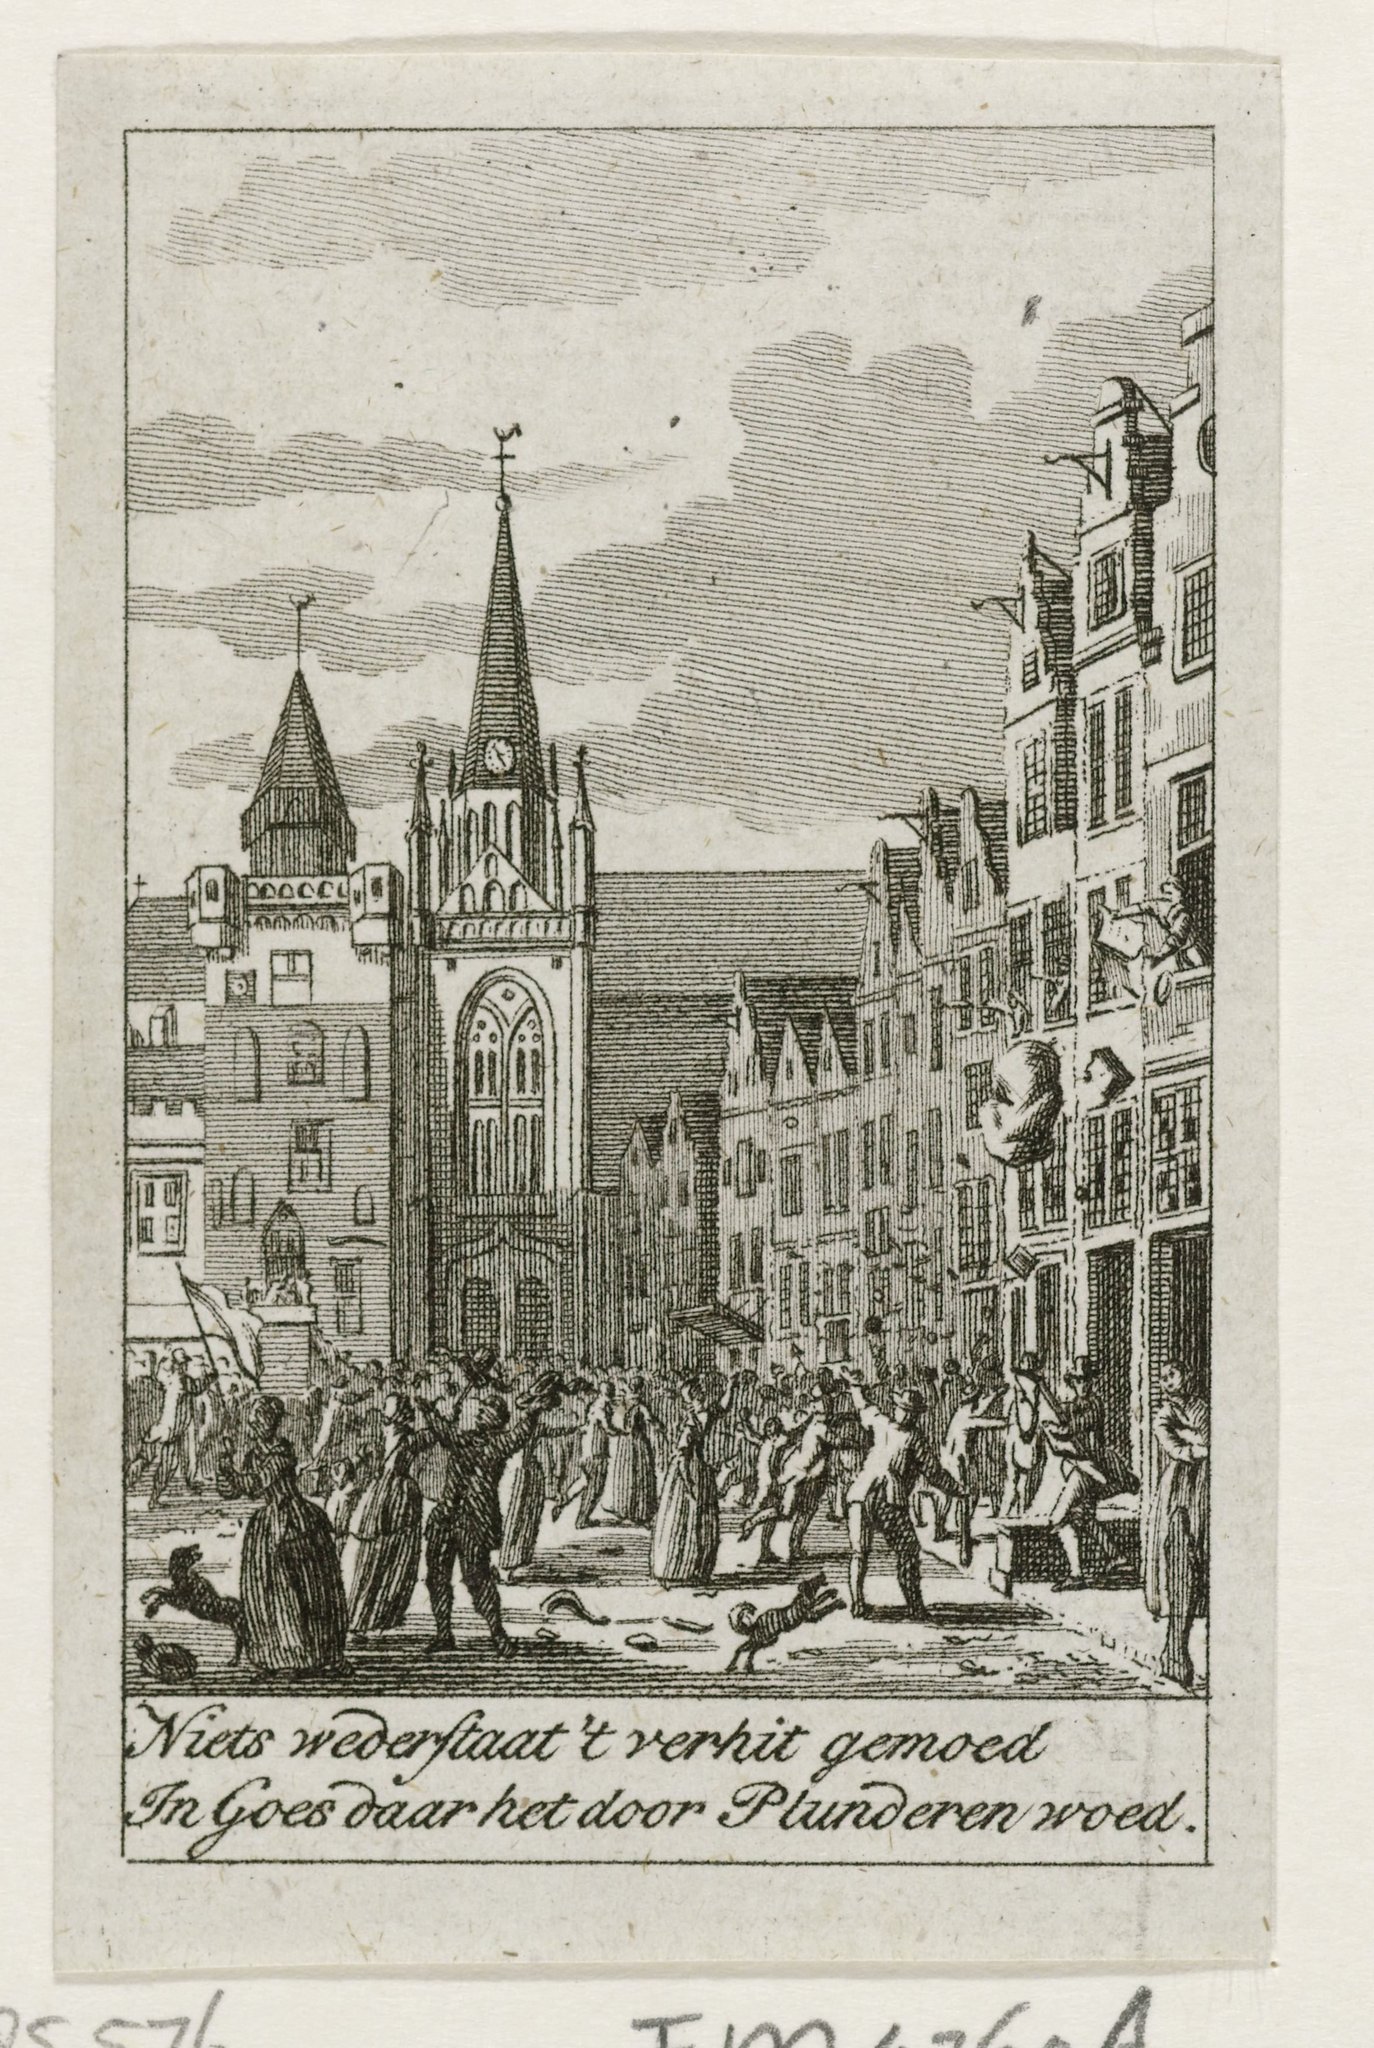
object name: print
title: Oproer door Prinsgezinden op de markt te Goes, 1787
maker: Anonymous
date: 1787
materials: paper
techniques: etching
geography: northern netherlands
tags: street-fights, riots, patriots (1780-1795)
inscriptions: collector's mark: Lugt 2228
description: Het oproer en plundering aangesticht door Prinsgezinden op de markt te Goes, 30 januari 1787. Gezicht op de Markt met het stadhuis en de Grote Kerk.